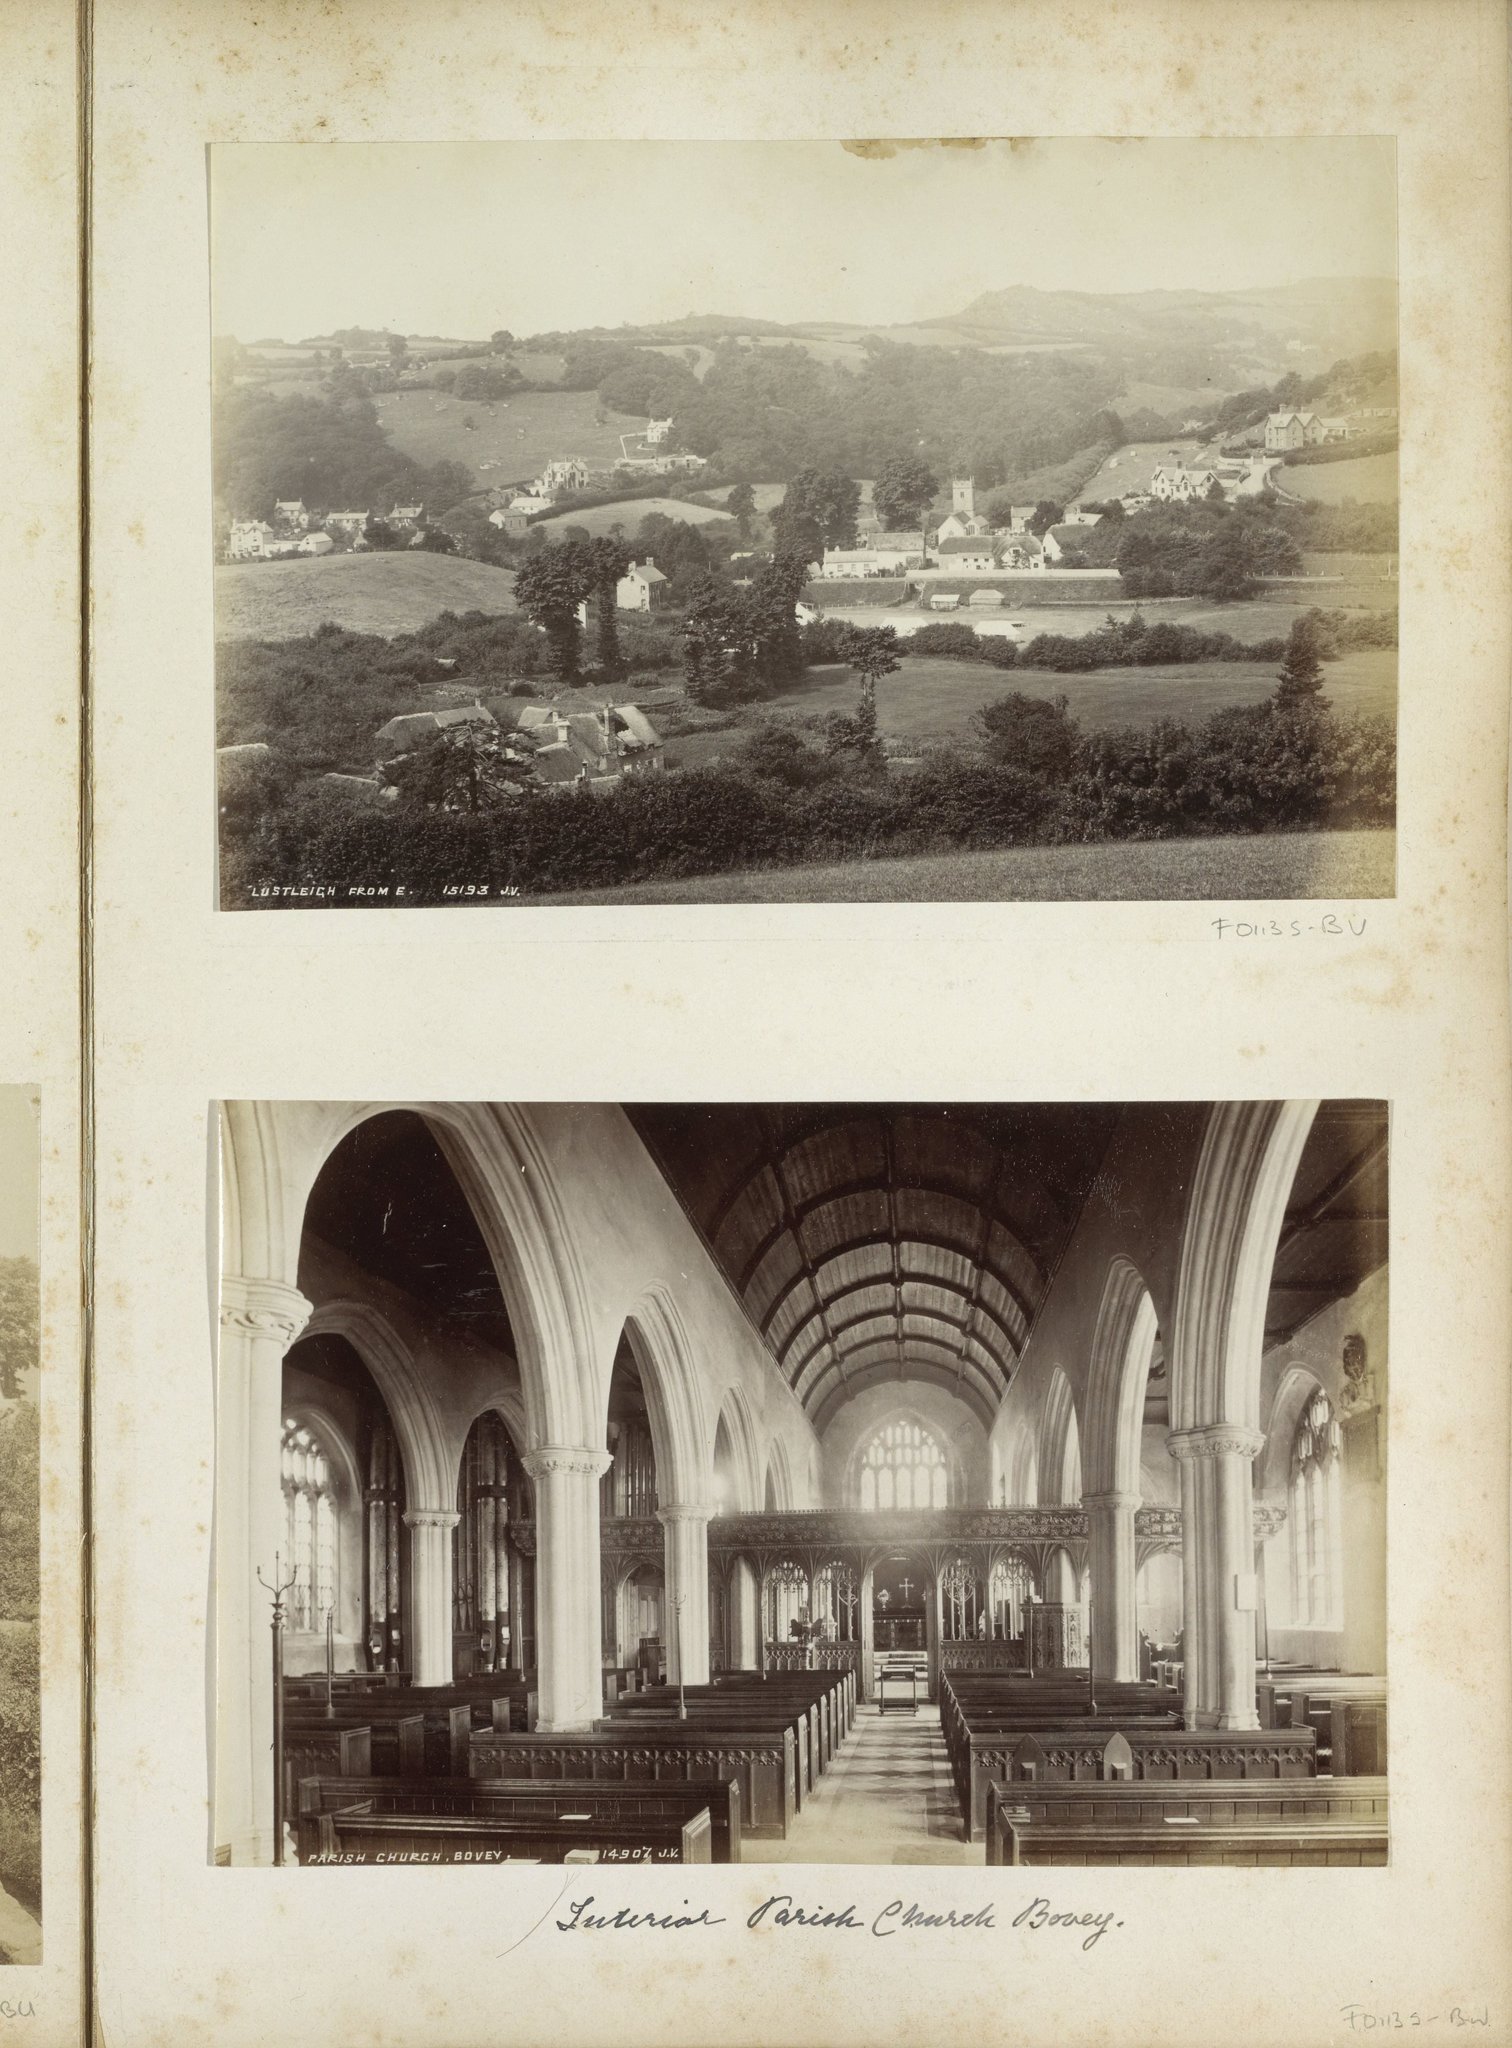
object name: album leaf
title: Parish Church, Bovey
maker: james valentine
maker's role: fotograaf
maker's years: 1815-1880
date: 1899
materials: paper, photographic support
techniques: albumen print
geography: bovey tracey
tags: rood-screen, choir-screen; iconostasis, parts of church interior: nave, interior of church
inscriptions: negative number: ‘14907’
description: Onderdeel van Reisalbum met foto's van bezienswaardigheden in Engeland en Frankrijk.